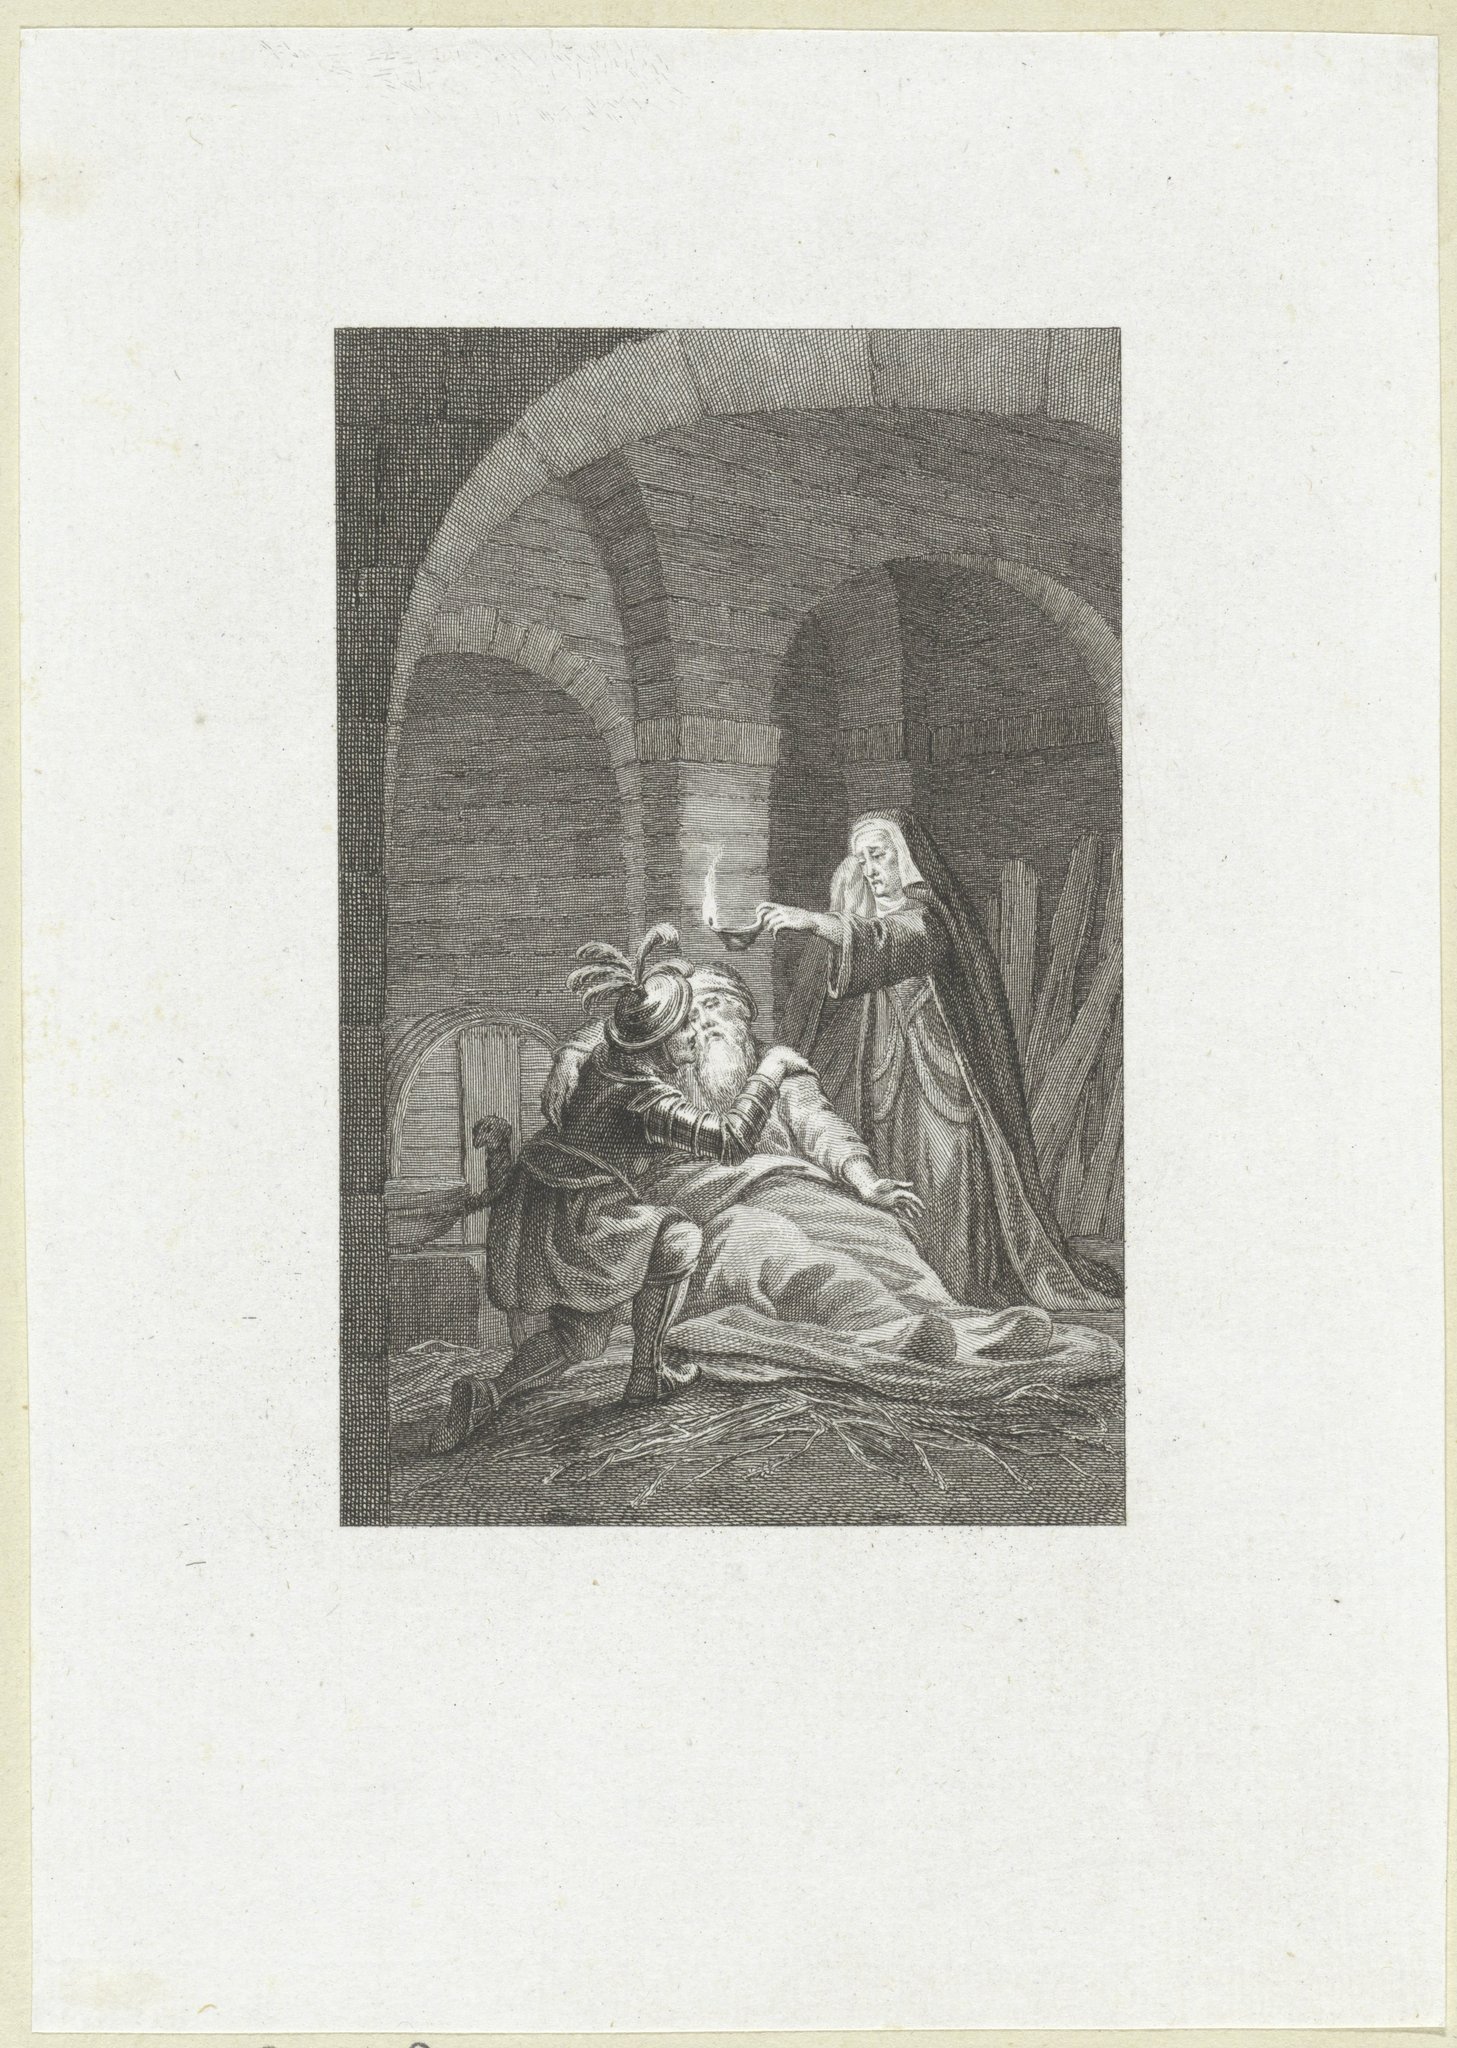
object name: print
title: Soldaat omhelst een oude man in een cel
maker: reinier vinkeles (i)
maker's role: draughtsman, print maker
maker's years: 1741-1816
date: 1783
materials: paper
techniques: engraving, etching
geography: amsterdam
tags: prison, jail, embracing each other, kissing, old man, oil-lamp, the soldier; the soldier's life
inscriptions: collector's mark: Lugt 240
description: Proefdruk van een prent die ook gebruikt is als illustratie bij het verhaal 'Valmiers' voor: Baculard d'Arnaud, F.T.M. de. Zedelijke verhaalen, deel 8. Amsterdam: A. Mens Jansz., 1783.